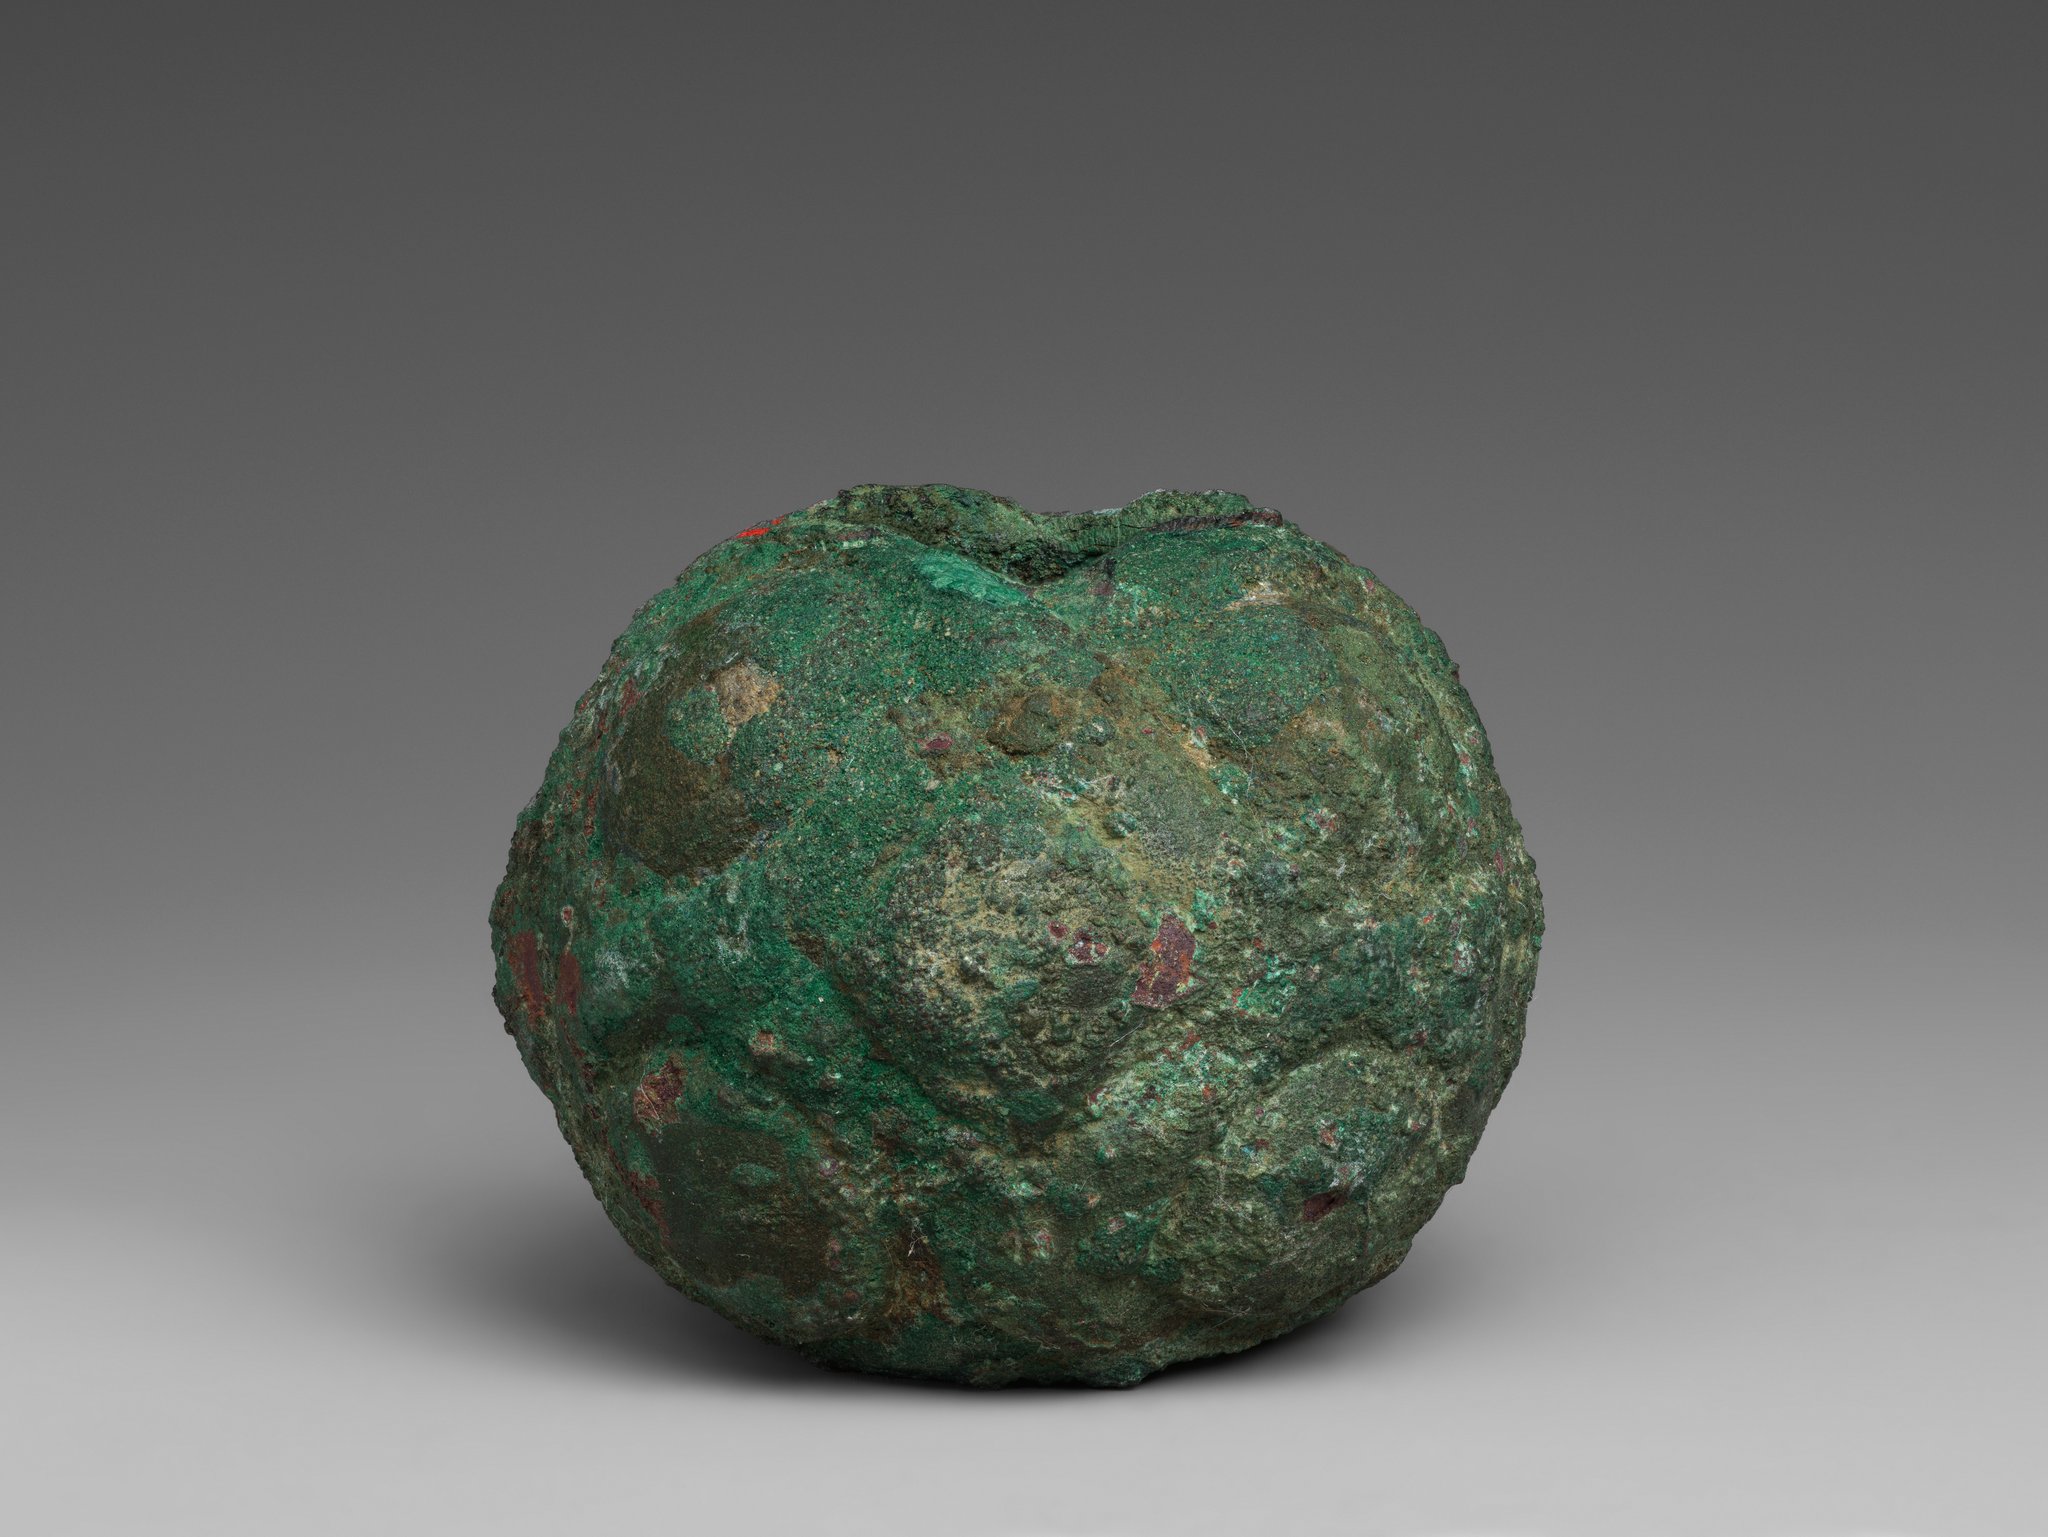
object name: mace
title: Mace head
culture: bactria-margiana archaeological complex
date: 2333-1668 BCE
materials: copper alloy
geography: bactria-margiana